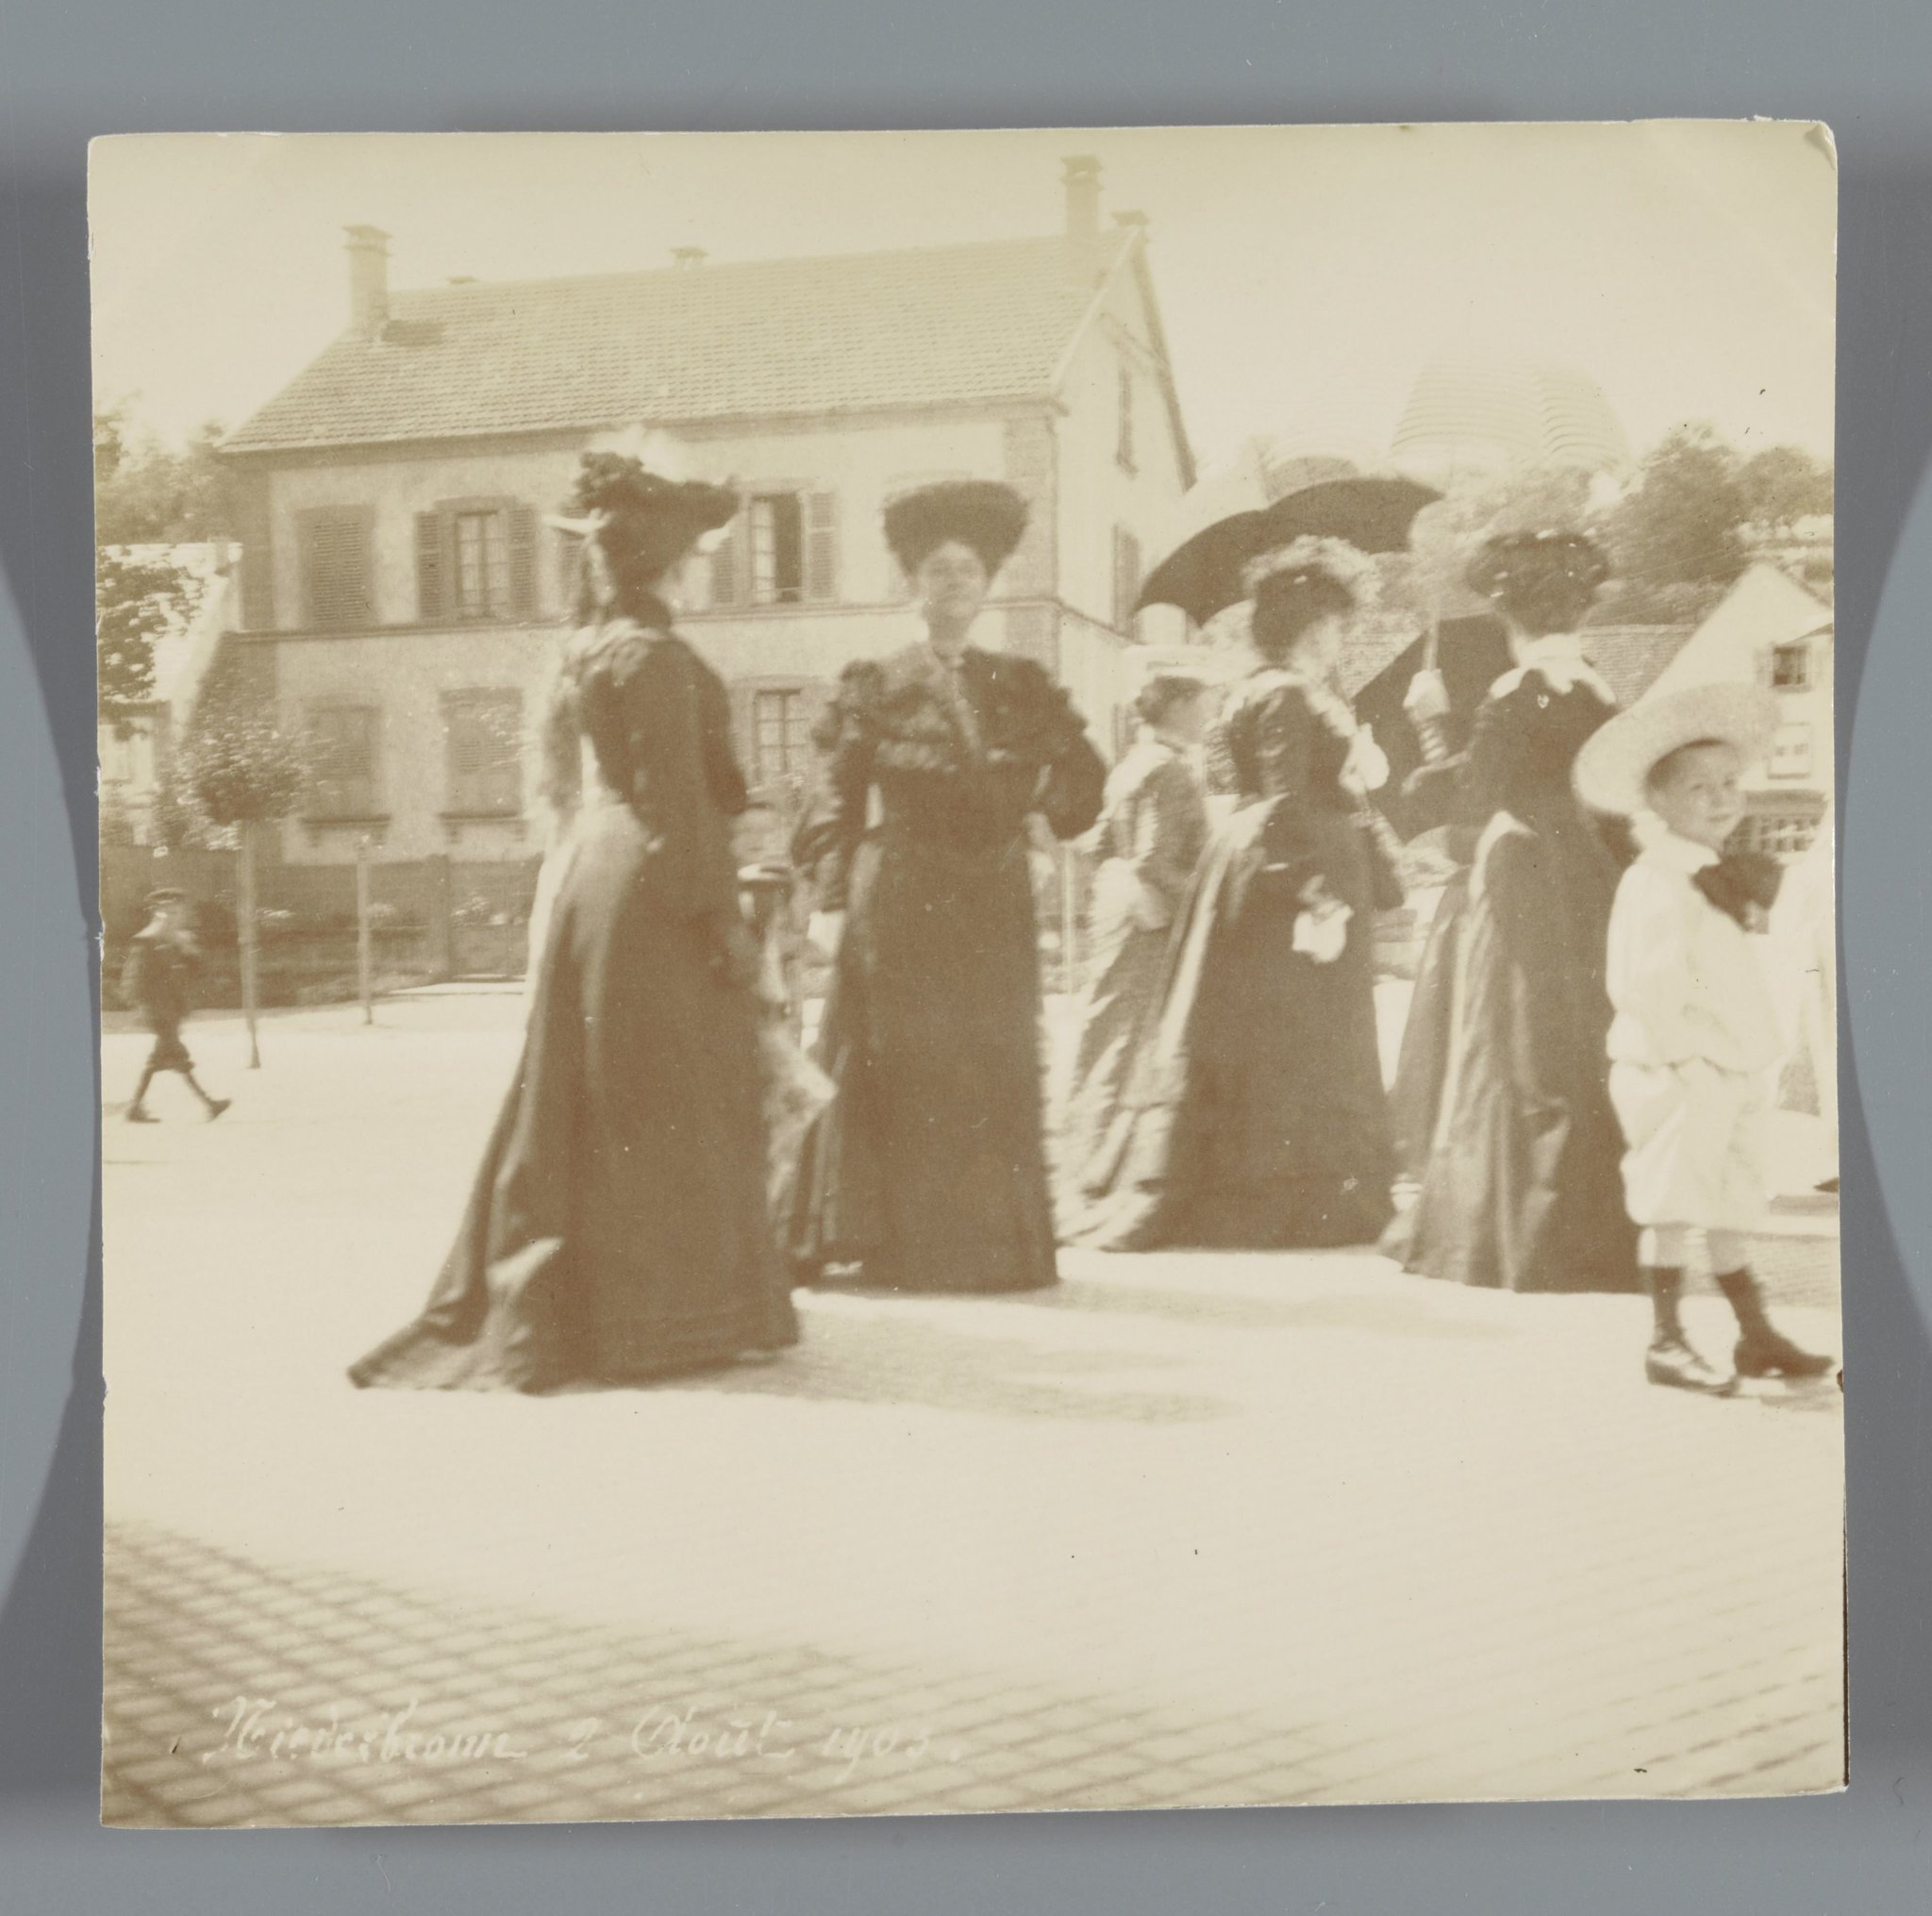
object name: photograph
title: Vrouwen op straat, Niederbronn (Bas-Rhin), Frankrijkijk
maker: Anonymous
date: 1903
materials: paper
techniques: gelatin silver print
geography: france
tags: public road in village (+ city(-scape) with figures, staffage), france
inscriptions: annotation: ‘Niederbronn 2 Août 1903’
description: Vrouwen op straat, Niederbronn (Bas-Rhin), Frankrijk.